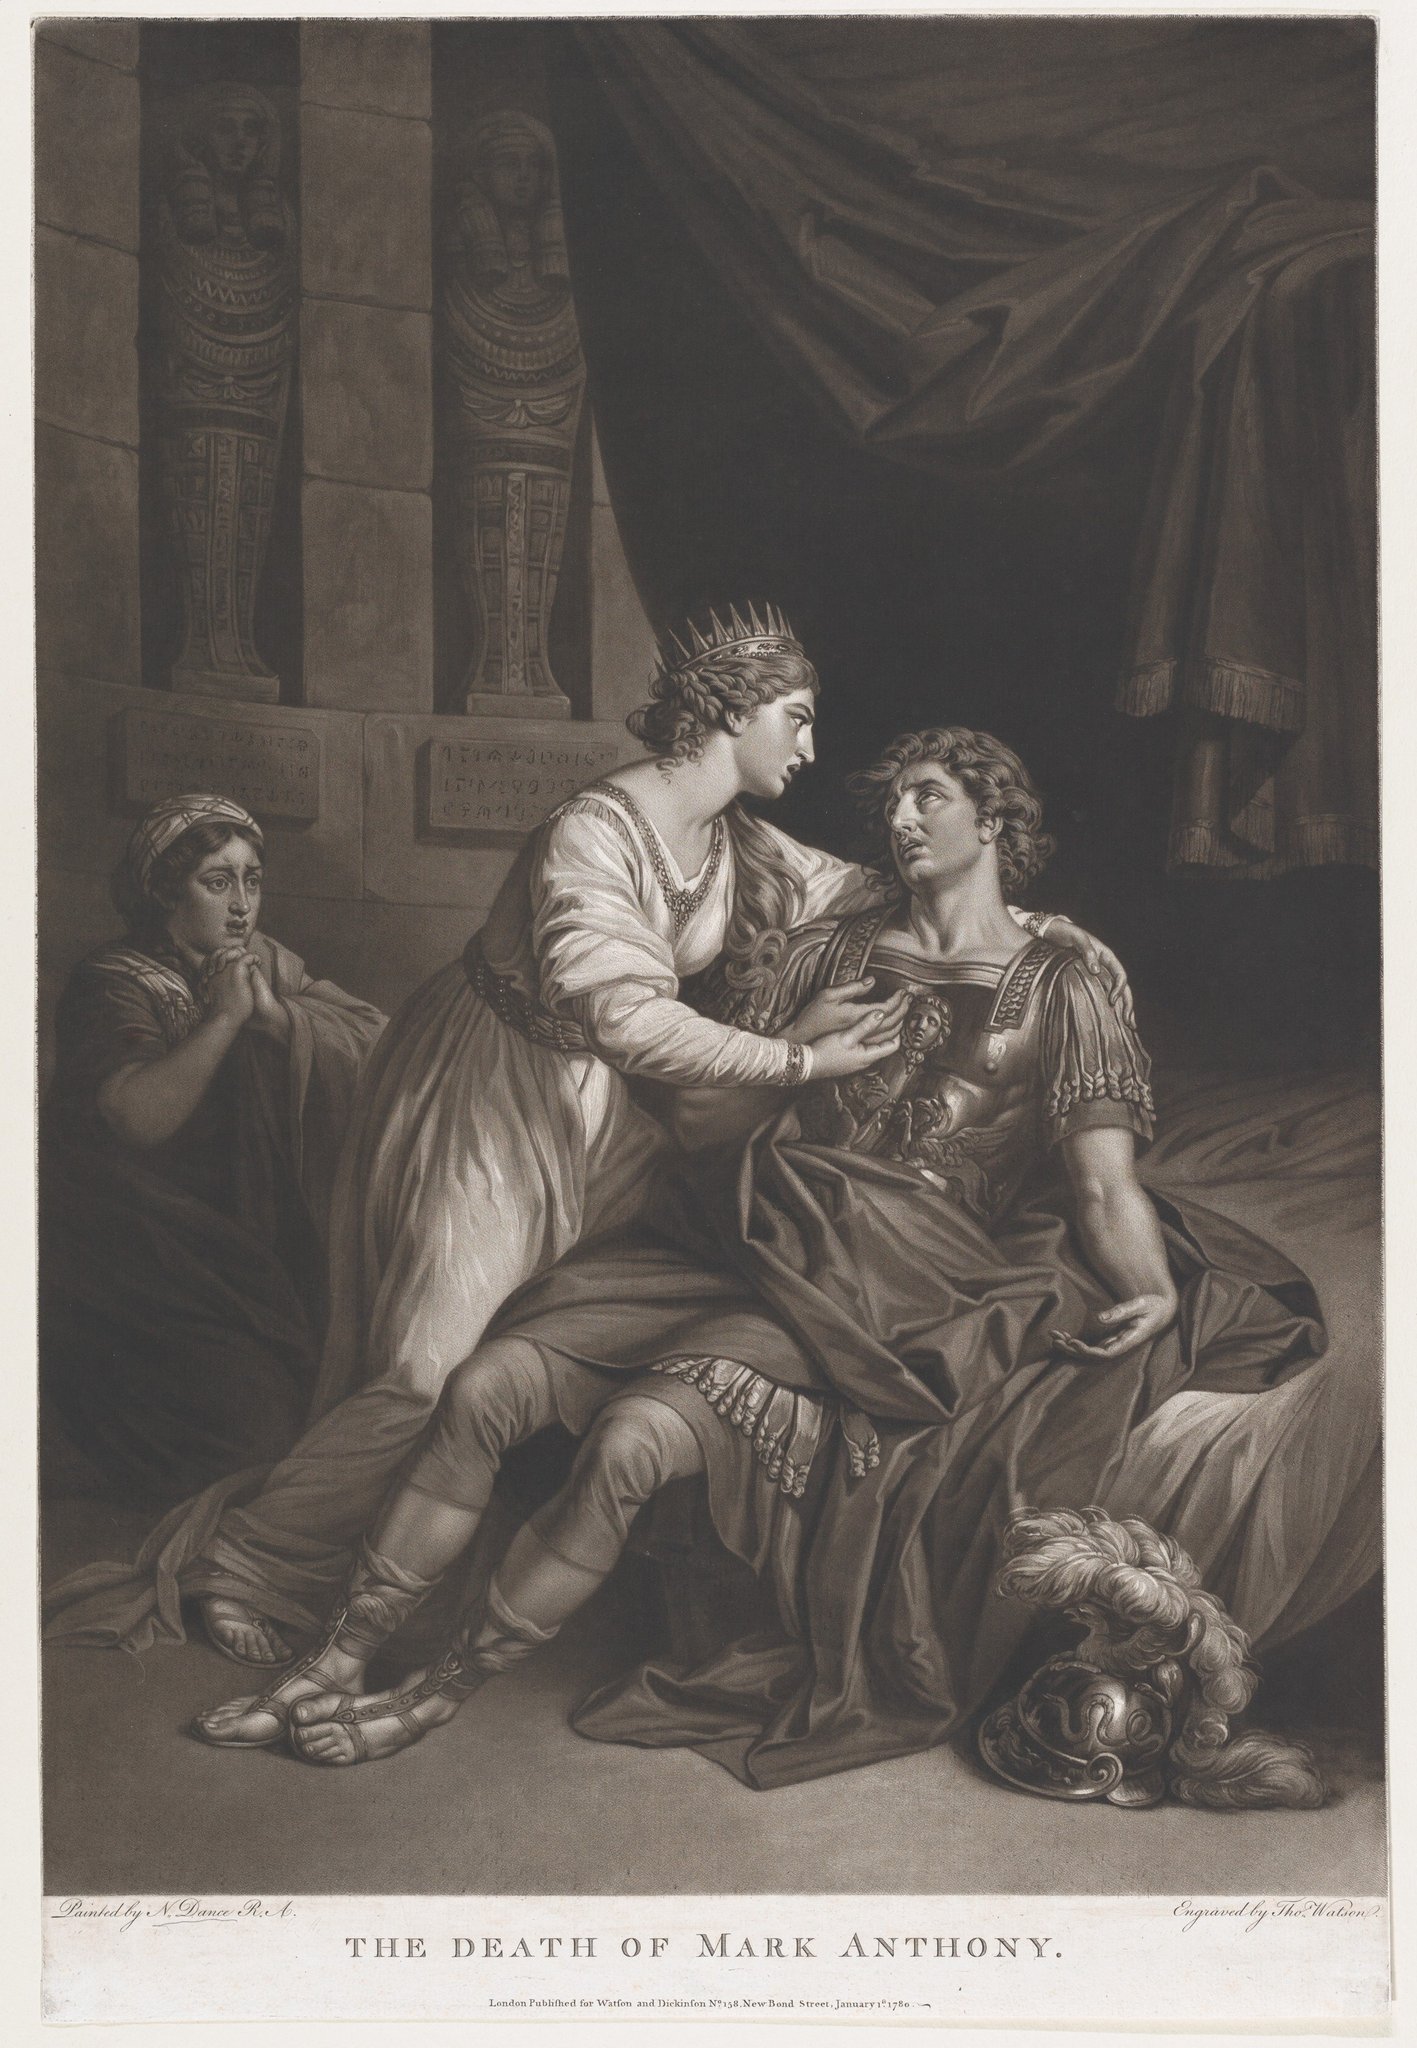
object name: print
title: The Death of Mark Antony (Shakespeare, Antony and Cleopatra, Act 4, Scene 15)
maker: thomas watson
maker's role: engraver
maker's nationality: english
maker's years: 1743-1781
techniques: mezzotint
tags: cleopatra,mark antony,shakespeare,women